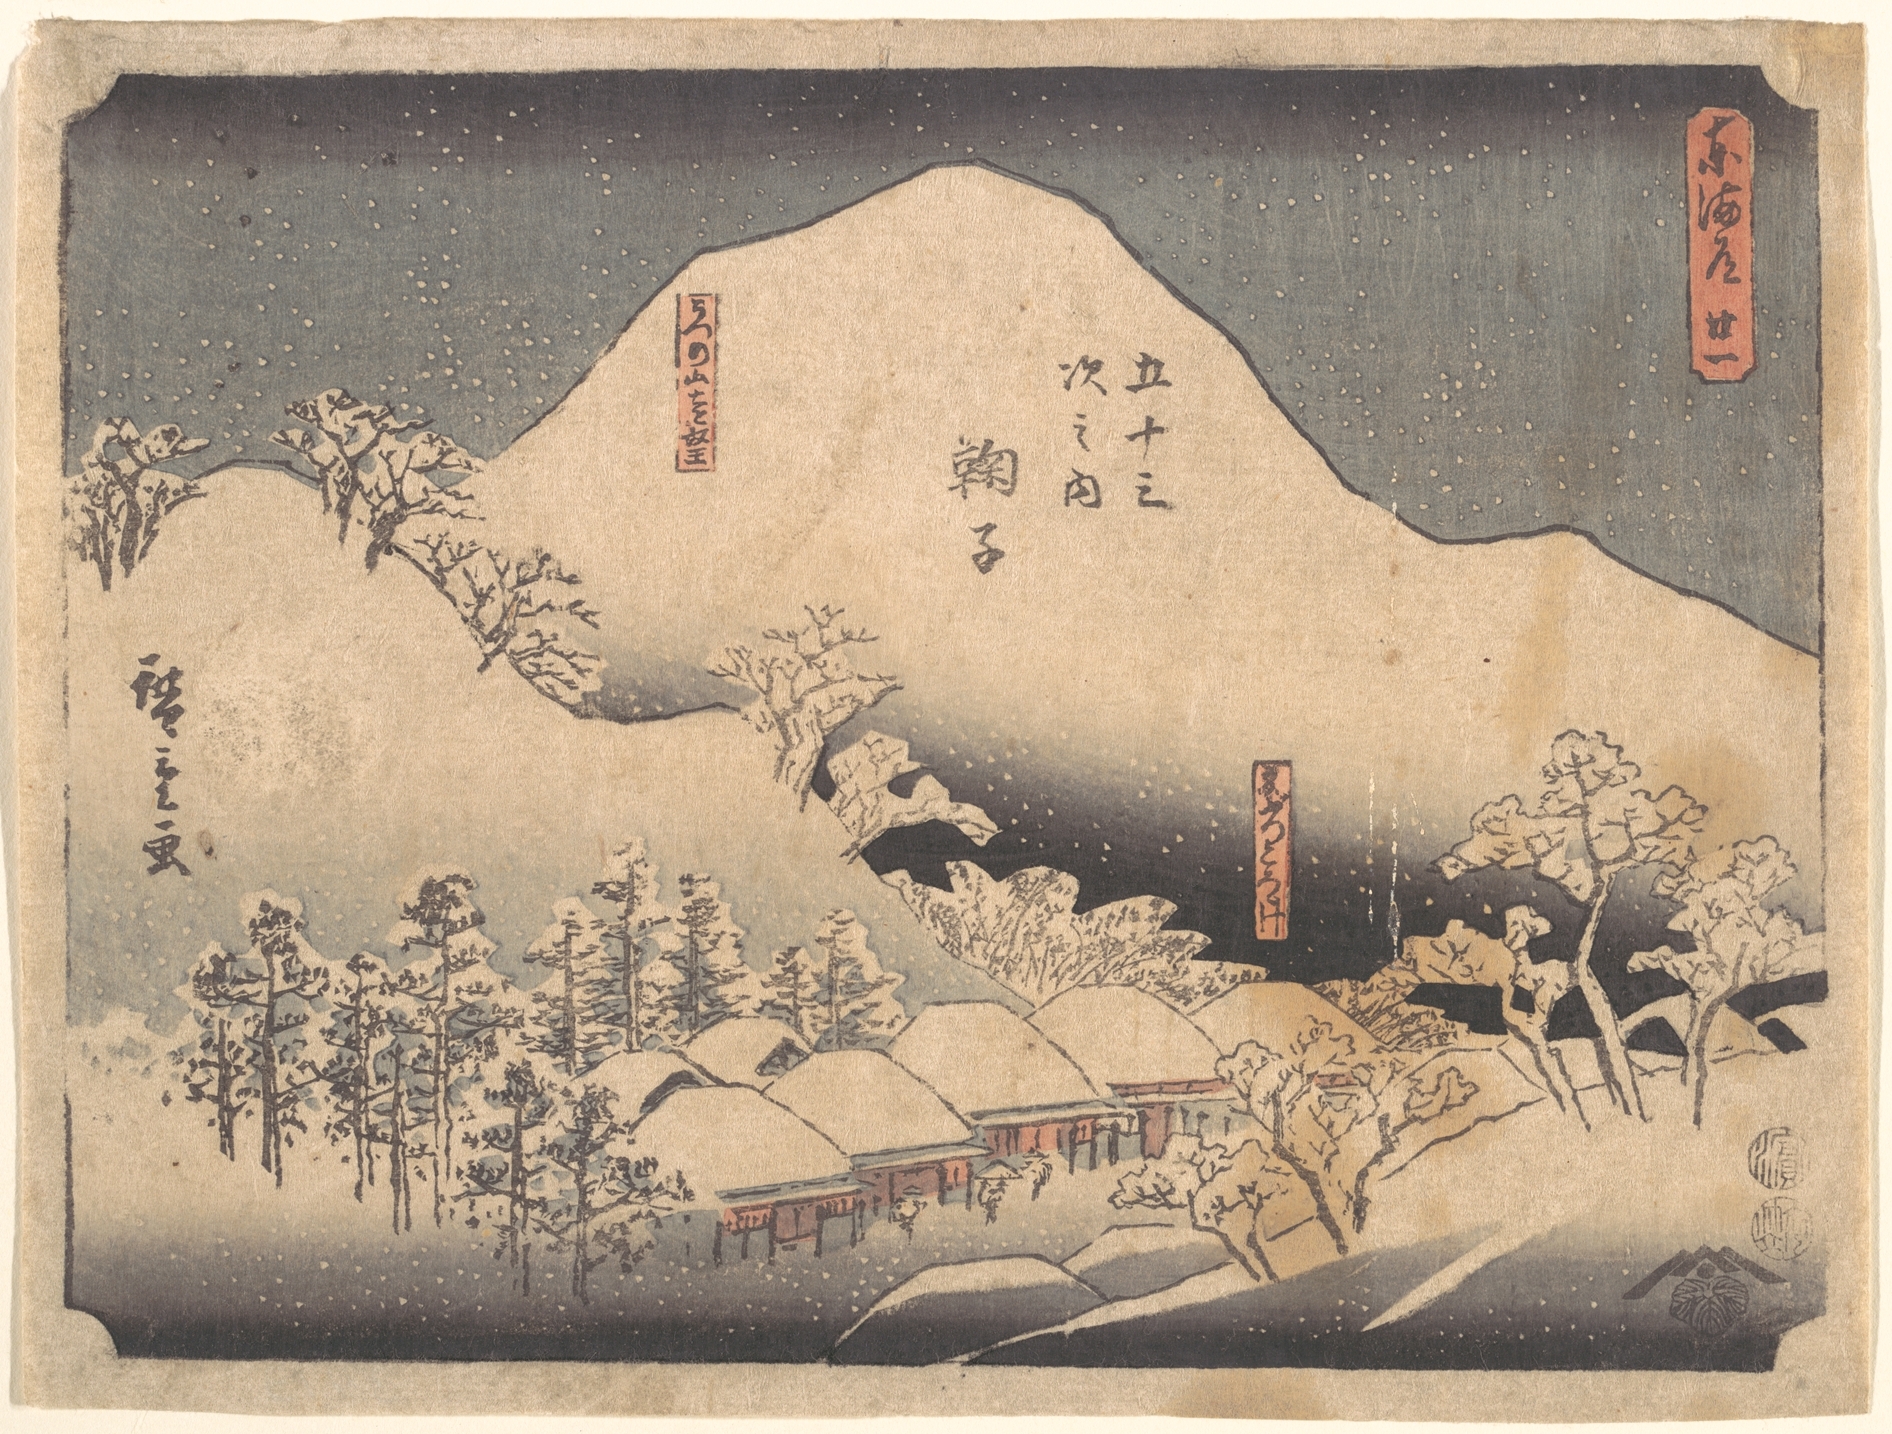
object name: print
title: Snowy Landscape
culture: japanese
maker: utagawa hiroshige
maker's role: artist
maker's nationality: japanese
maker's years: 1797-1858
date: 1850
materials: ink, paper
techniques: woodblock print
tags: houses,mountains,landscapes,snow